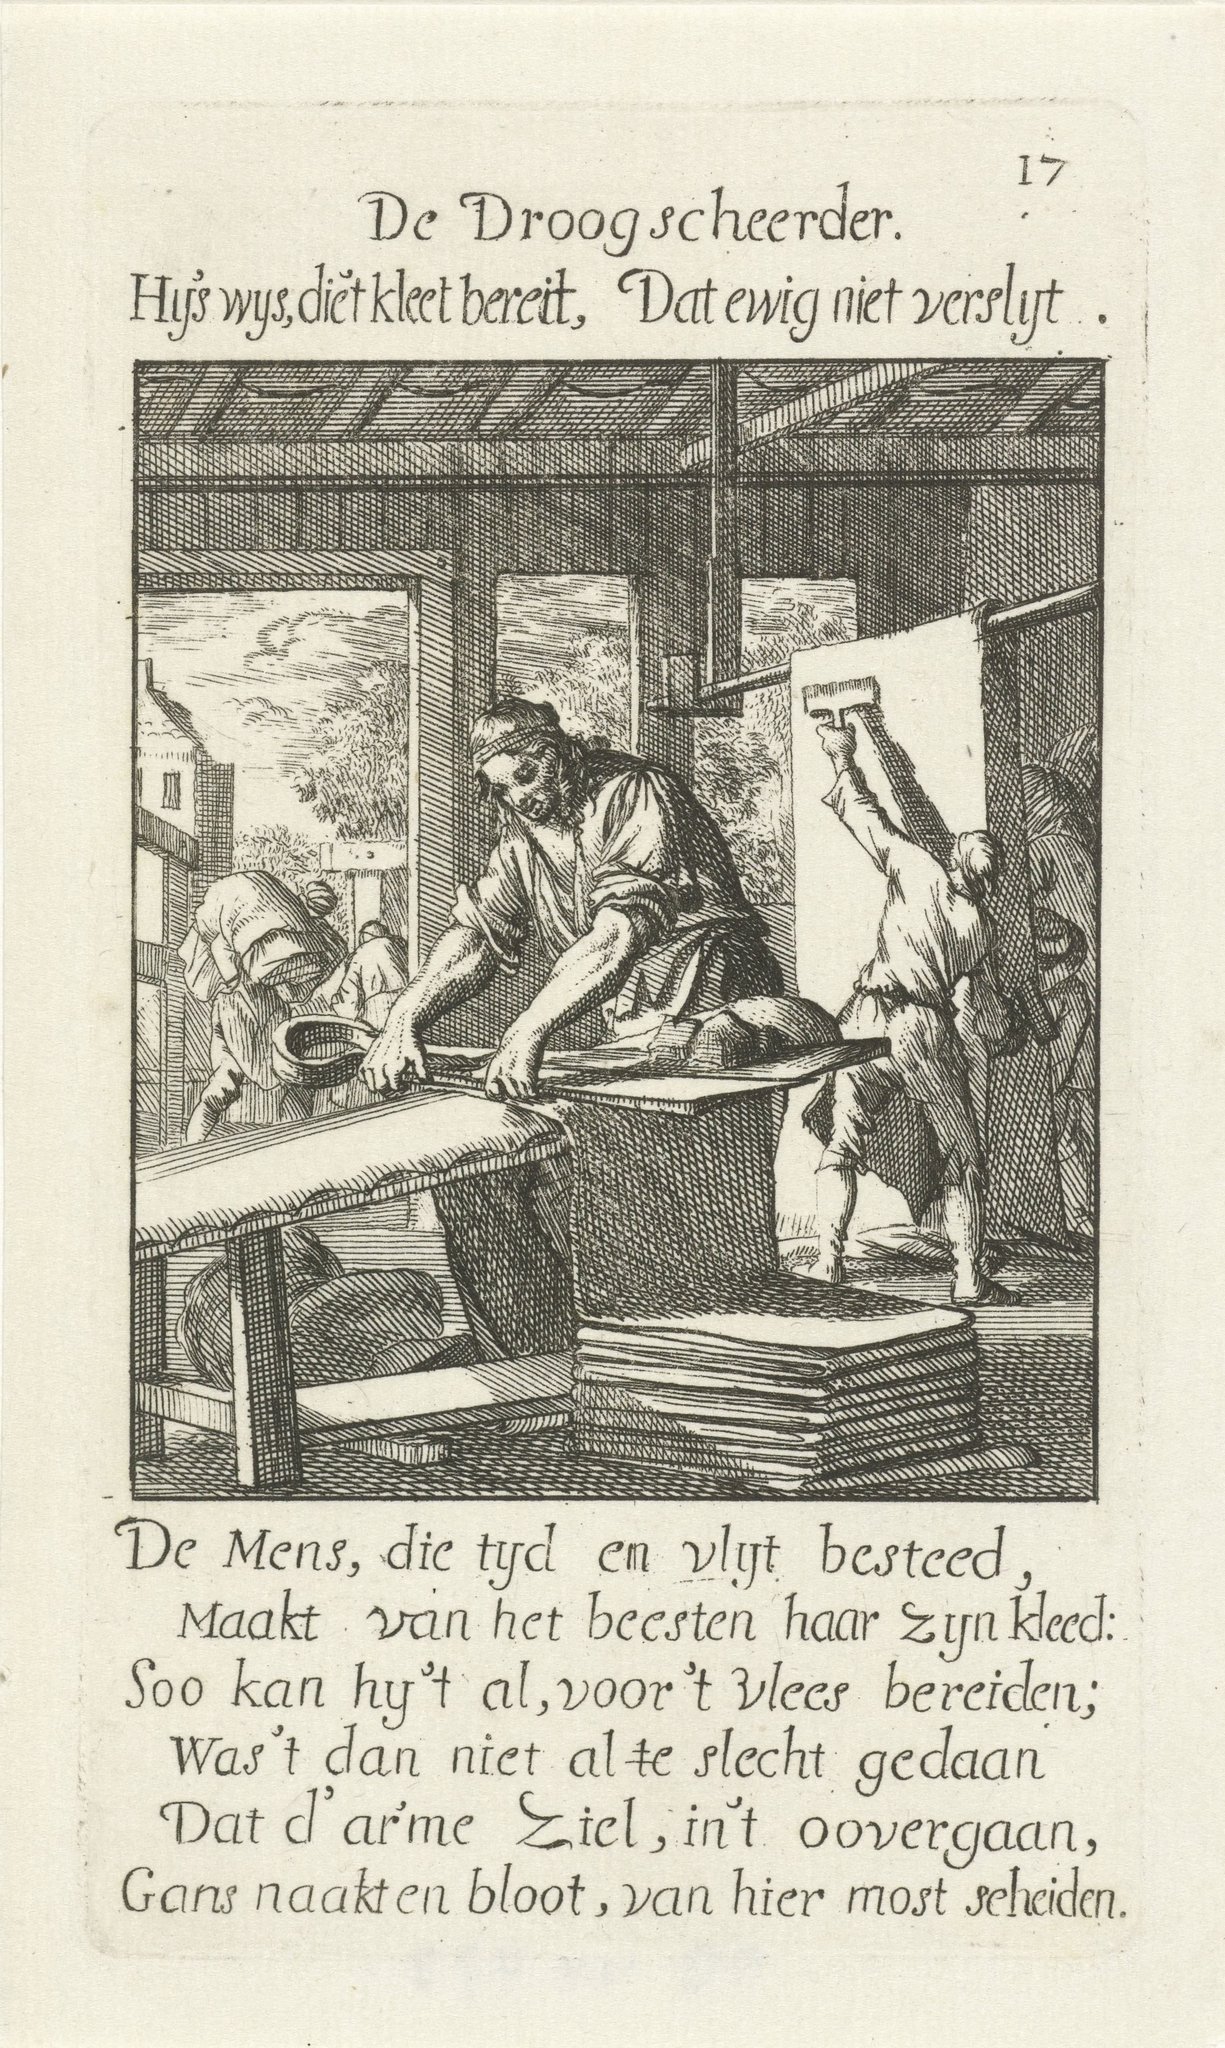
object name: print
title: Het Menselyk Bedryf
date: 1694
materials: paper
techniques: etching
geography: amsterdam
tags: sheet, handicrafts, craftsman at work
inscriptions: collector's mark: Lugt 2228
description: Maakt deel uit van de 100-delige serie beroepsprenten van Jan en Caspar Luyken, getiteld: Het menselyk bedryf. S.l.s.n., 1694 (eerste druk).